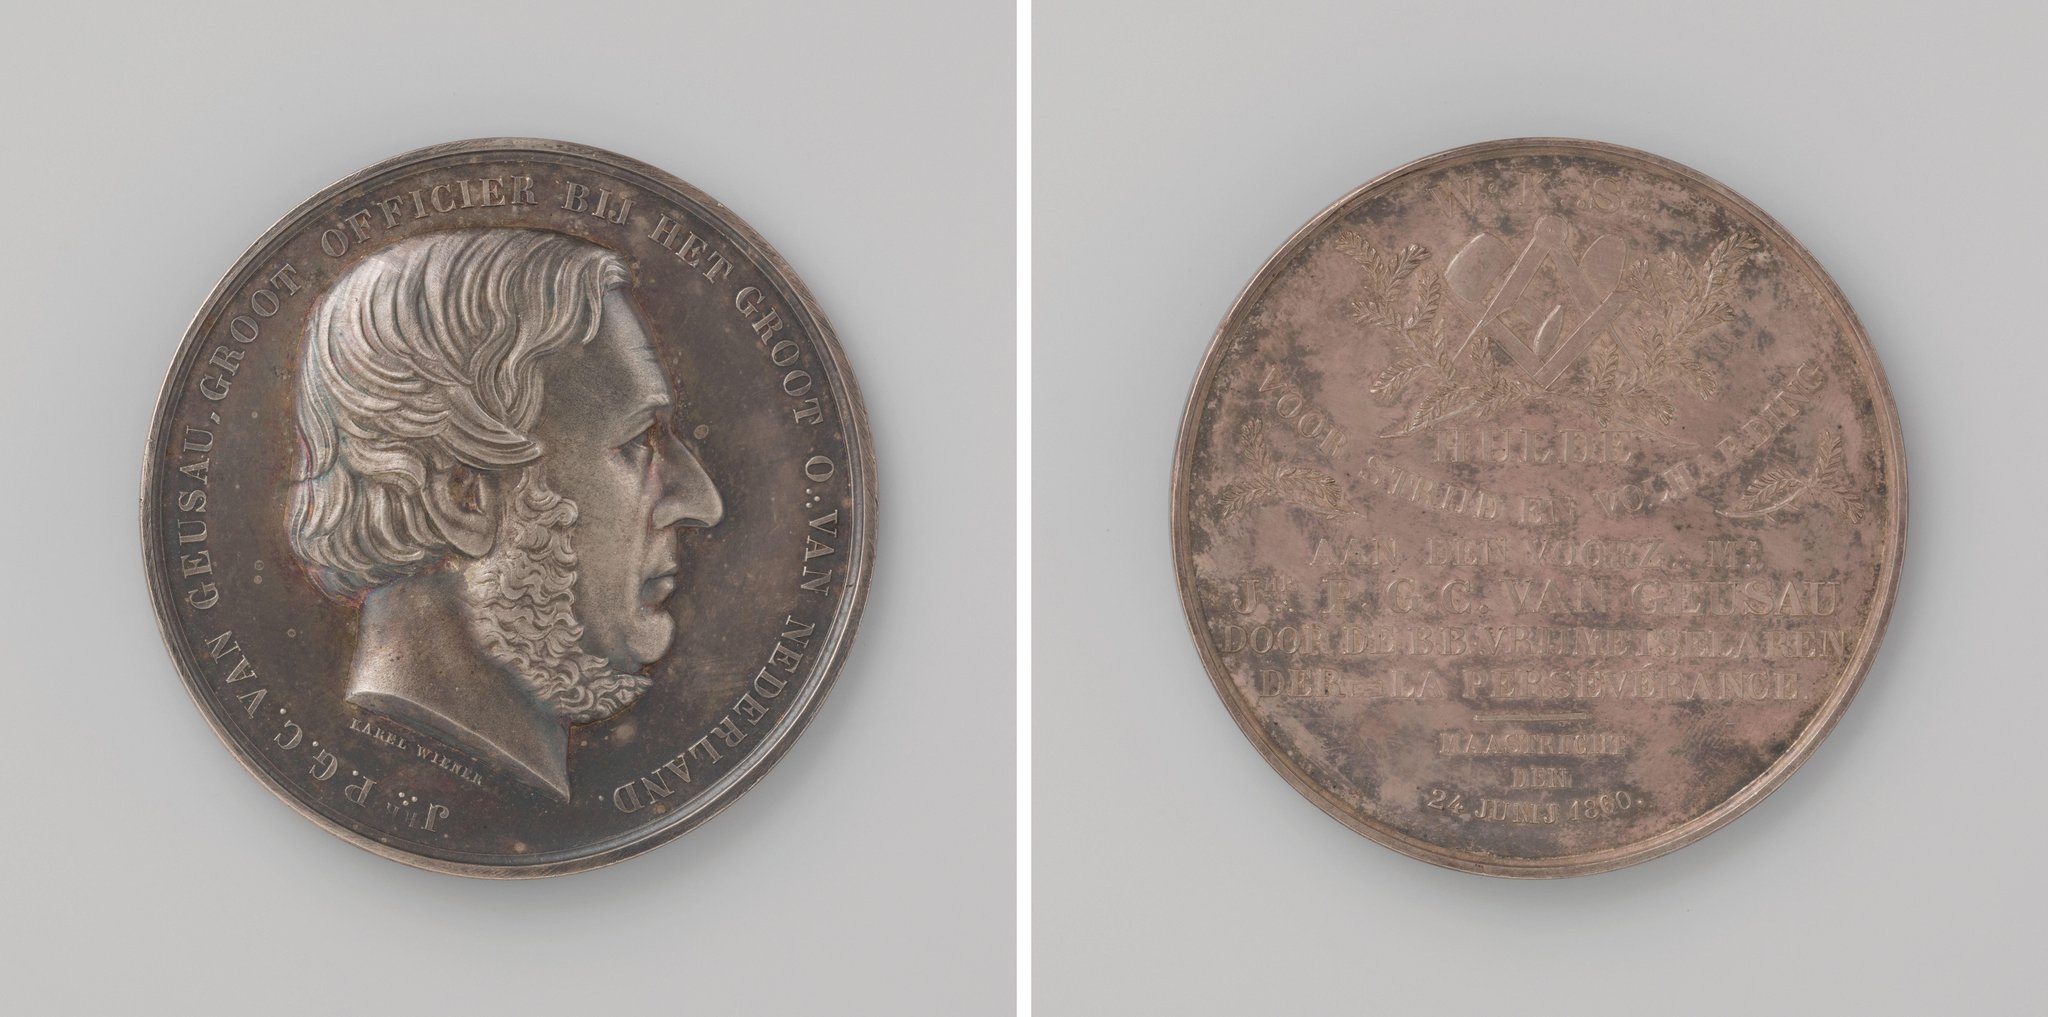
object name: honorary medal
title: P.G.C. Van Geusau, grootofficier van de loge "Groot Oosten van Nederland", penning aangeboden door de broeders van de loge "La Perseverance" te Maastricht aan hun voorzittend meester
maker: karel wiener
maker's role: medailleur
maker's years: 1831-1888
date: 1860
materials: silver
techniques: striking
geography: the hague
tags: maastricht, eijsden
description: Zilveren penning. Voorzijde: borststuk man binnen omschrift. Keerzijde: opschrift onder verweven passer, omgekeerde winkelhaak vrijmetselaarshamer en troffel tussen palmtakken